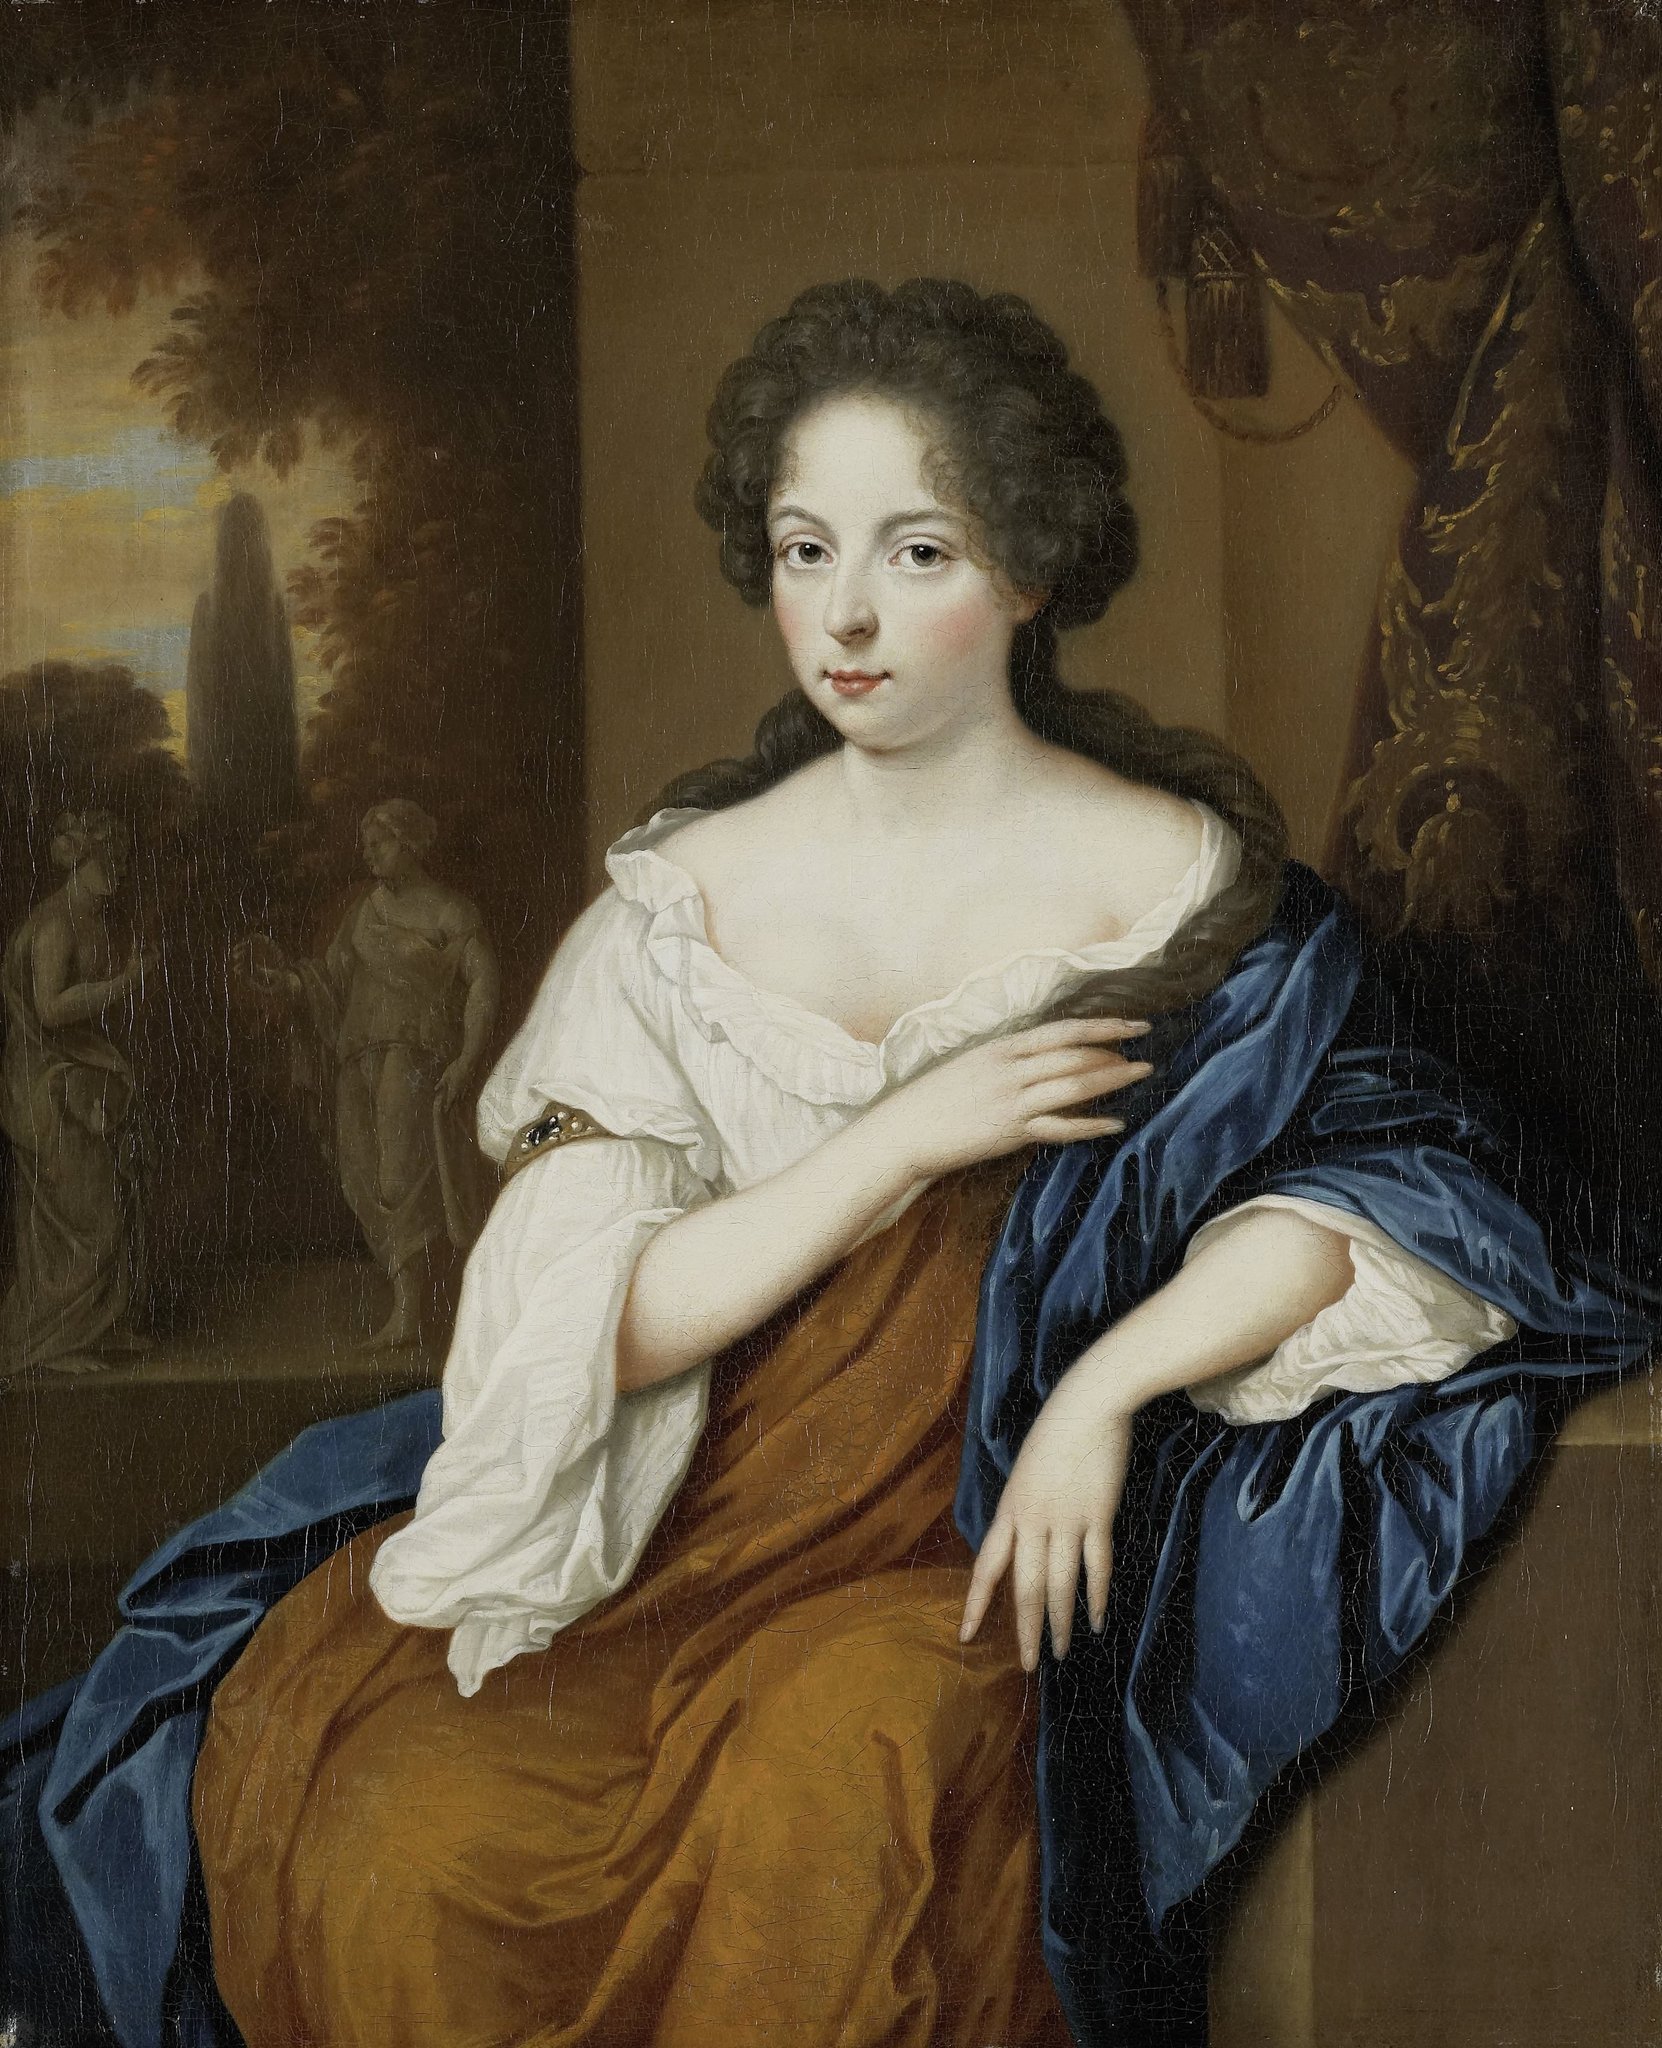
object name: painting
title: Portrait of a Woman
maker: jan van haensbergen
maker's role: painter, print maker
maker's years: 1642-1705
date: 1670-1700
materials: canvas, oil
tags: historical persons not known by name - bb - woman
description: Portret van een jonge vrouw, kniestuk zittend. Rechts een gordijn. links (een voorstelling van?) twee figuren in de tuin.